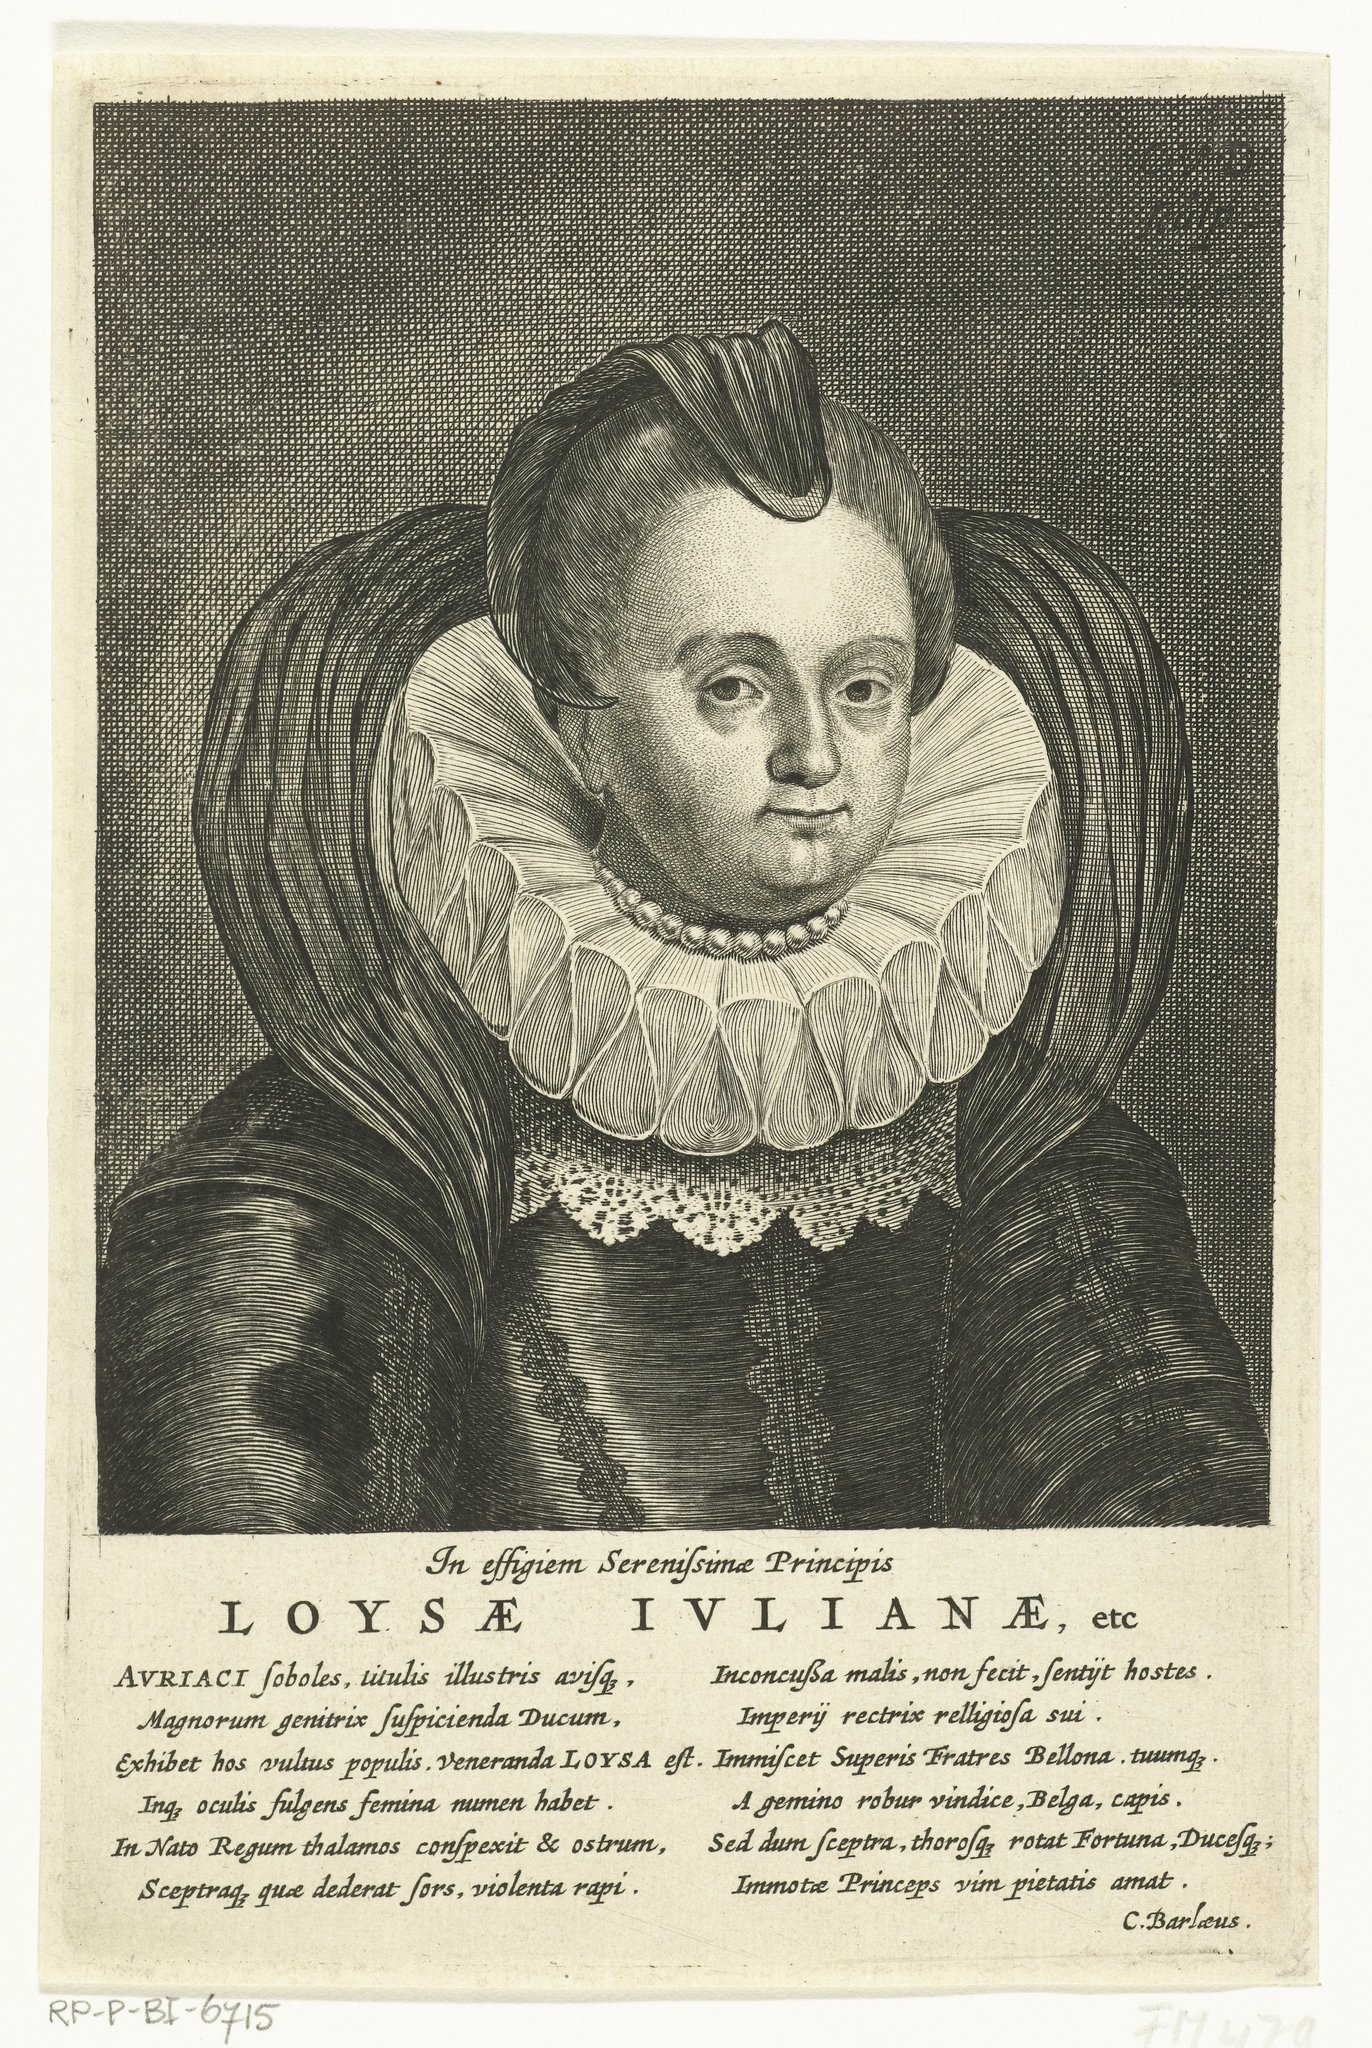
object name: print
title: In effigiem serenissimae principis Loysae Ivlianae etc.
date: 1612-1665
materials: paper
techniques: engraving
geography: amsterdam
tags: dordrecht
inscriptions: collector's mark: Lugt 2228, inscription: ‘F.M. 1884’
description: Portret van prinses Louise Juliana van Oranje-Nassau. Borststuk met onder in marge een vers van Caspar van Baerle uit zijn Poemata